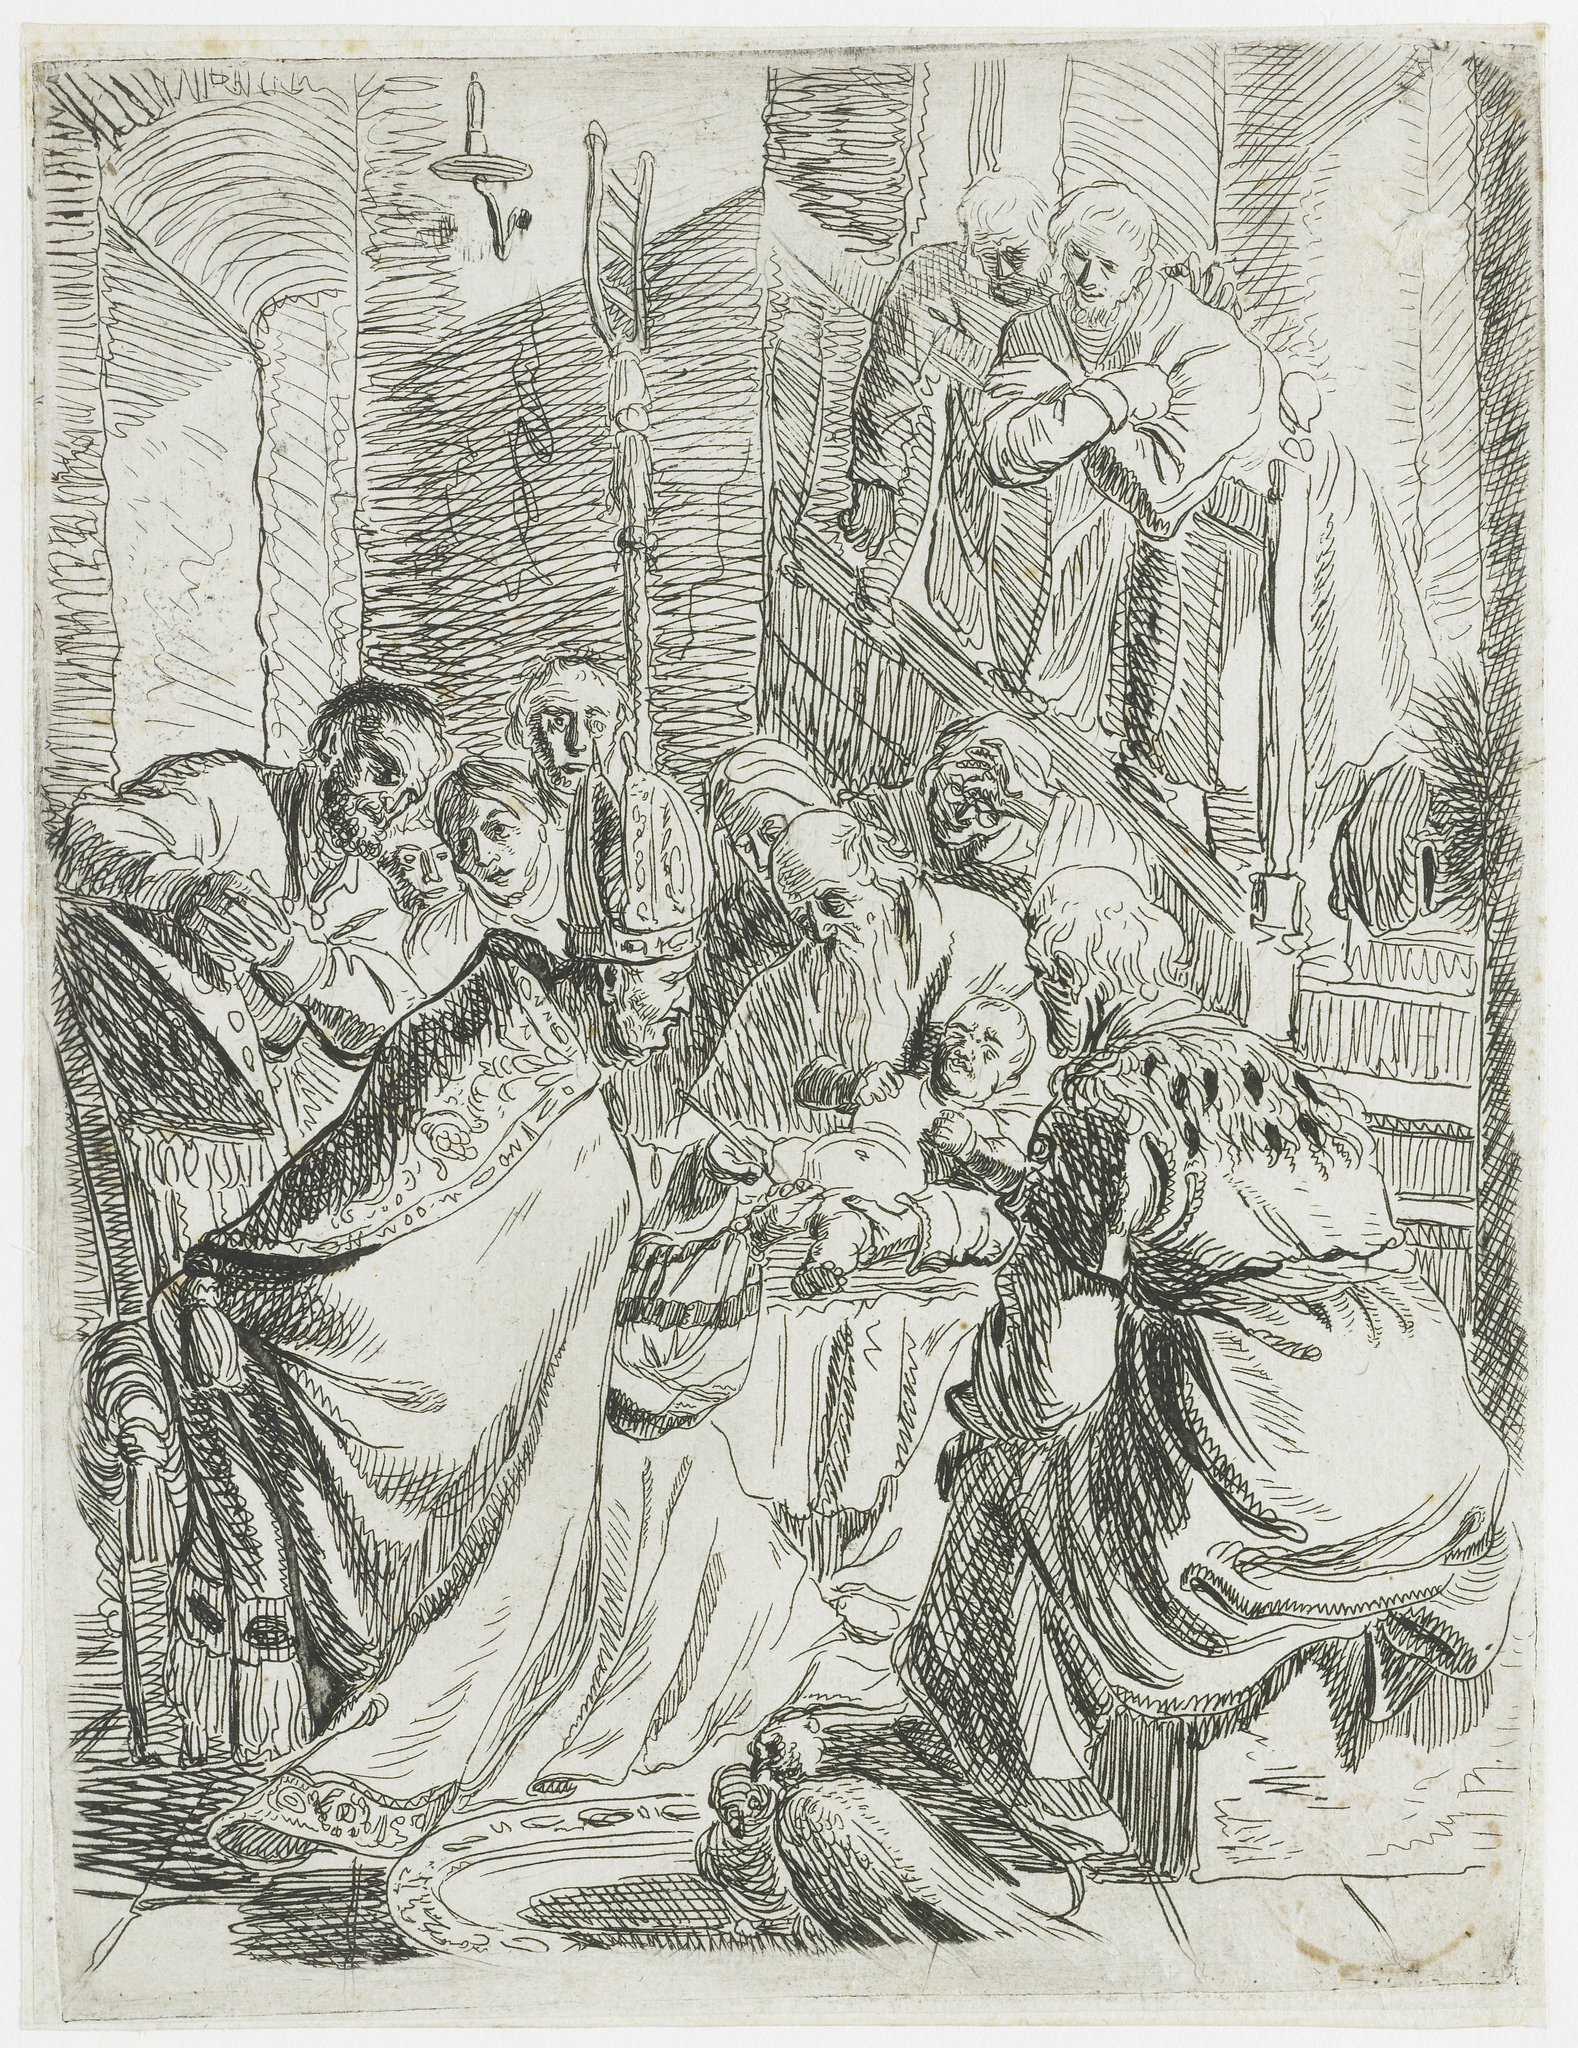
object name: print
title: The circumcision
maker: rembrandt van rijn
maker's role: draughtsman, painter, print maker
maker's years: 1606-1669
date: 1625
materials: paper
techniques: etching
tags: circumcision of the christ-child by the priest in the temple (luke 2:21)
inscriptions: collector's mark: Lugt 240, inscription: ‘Gout de N. 7’, inscription: ‘Moyaert / Bramu’ Moeyaert? en Bramer?